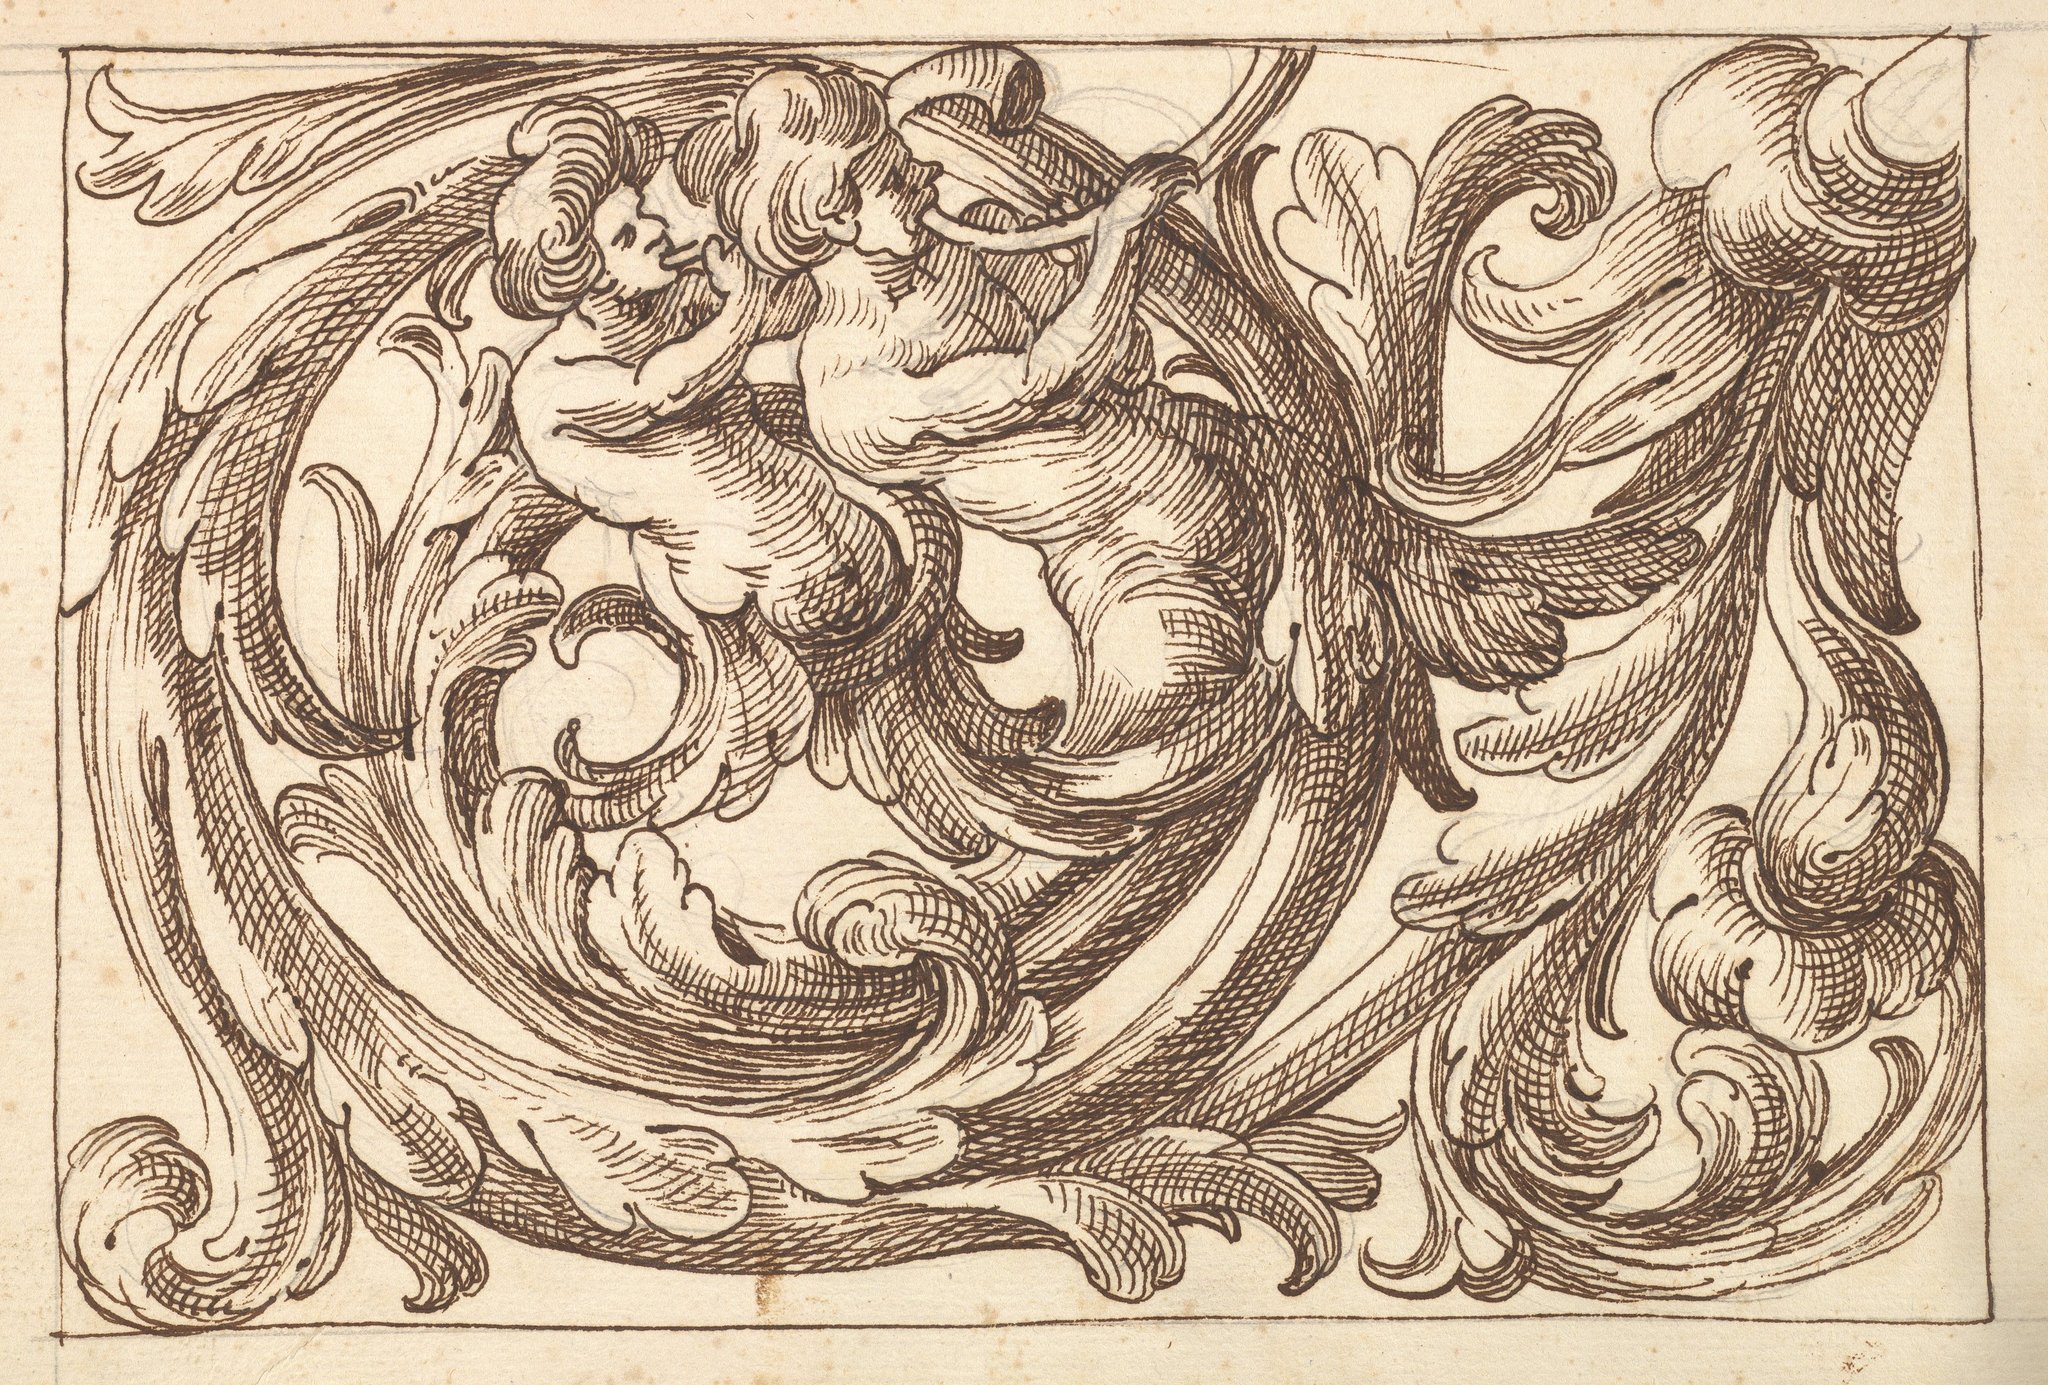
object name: collection ornament architecture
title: Horizontal Panel Design with Two Male Figures Playing Horns Interspersed between Acanthus Rinceaux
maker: anonymous, italian, venetian, 17th century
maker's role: artist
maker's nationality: italian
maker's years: 1600-1700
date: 1601-1700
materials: ink, drawing material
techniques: pen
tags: men,horns